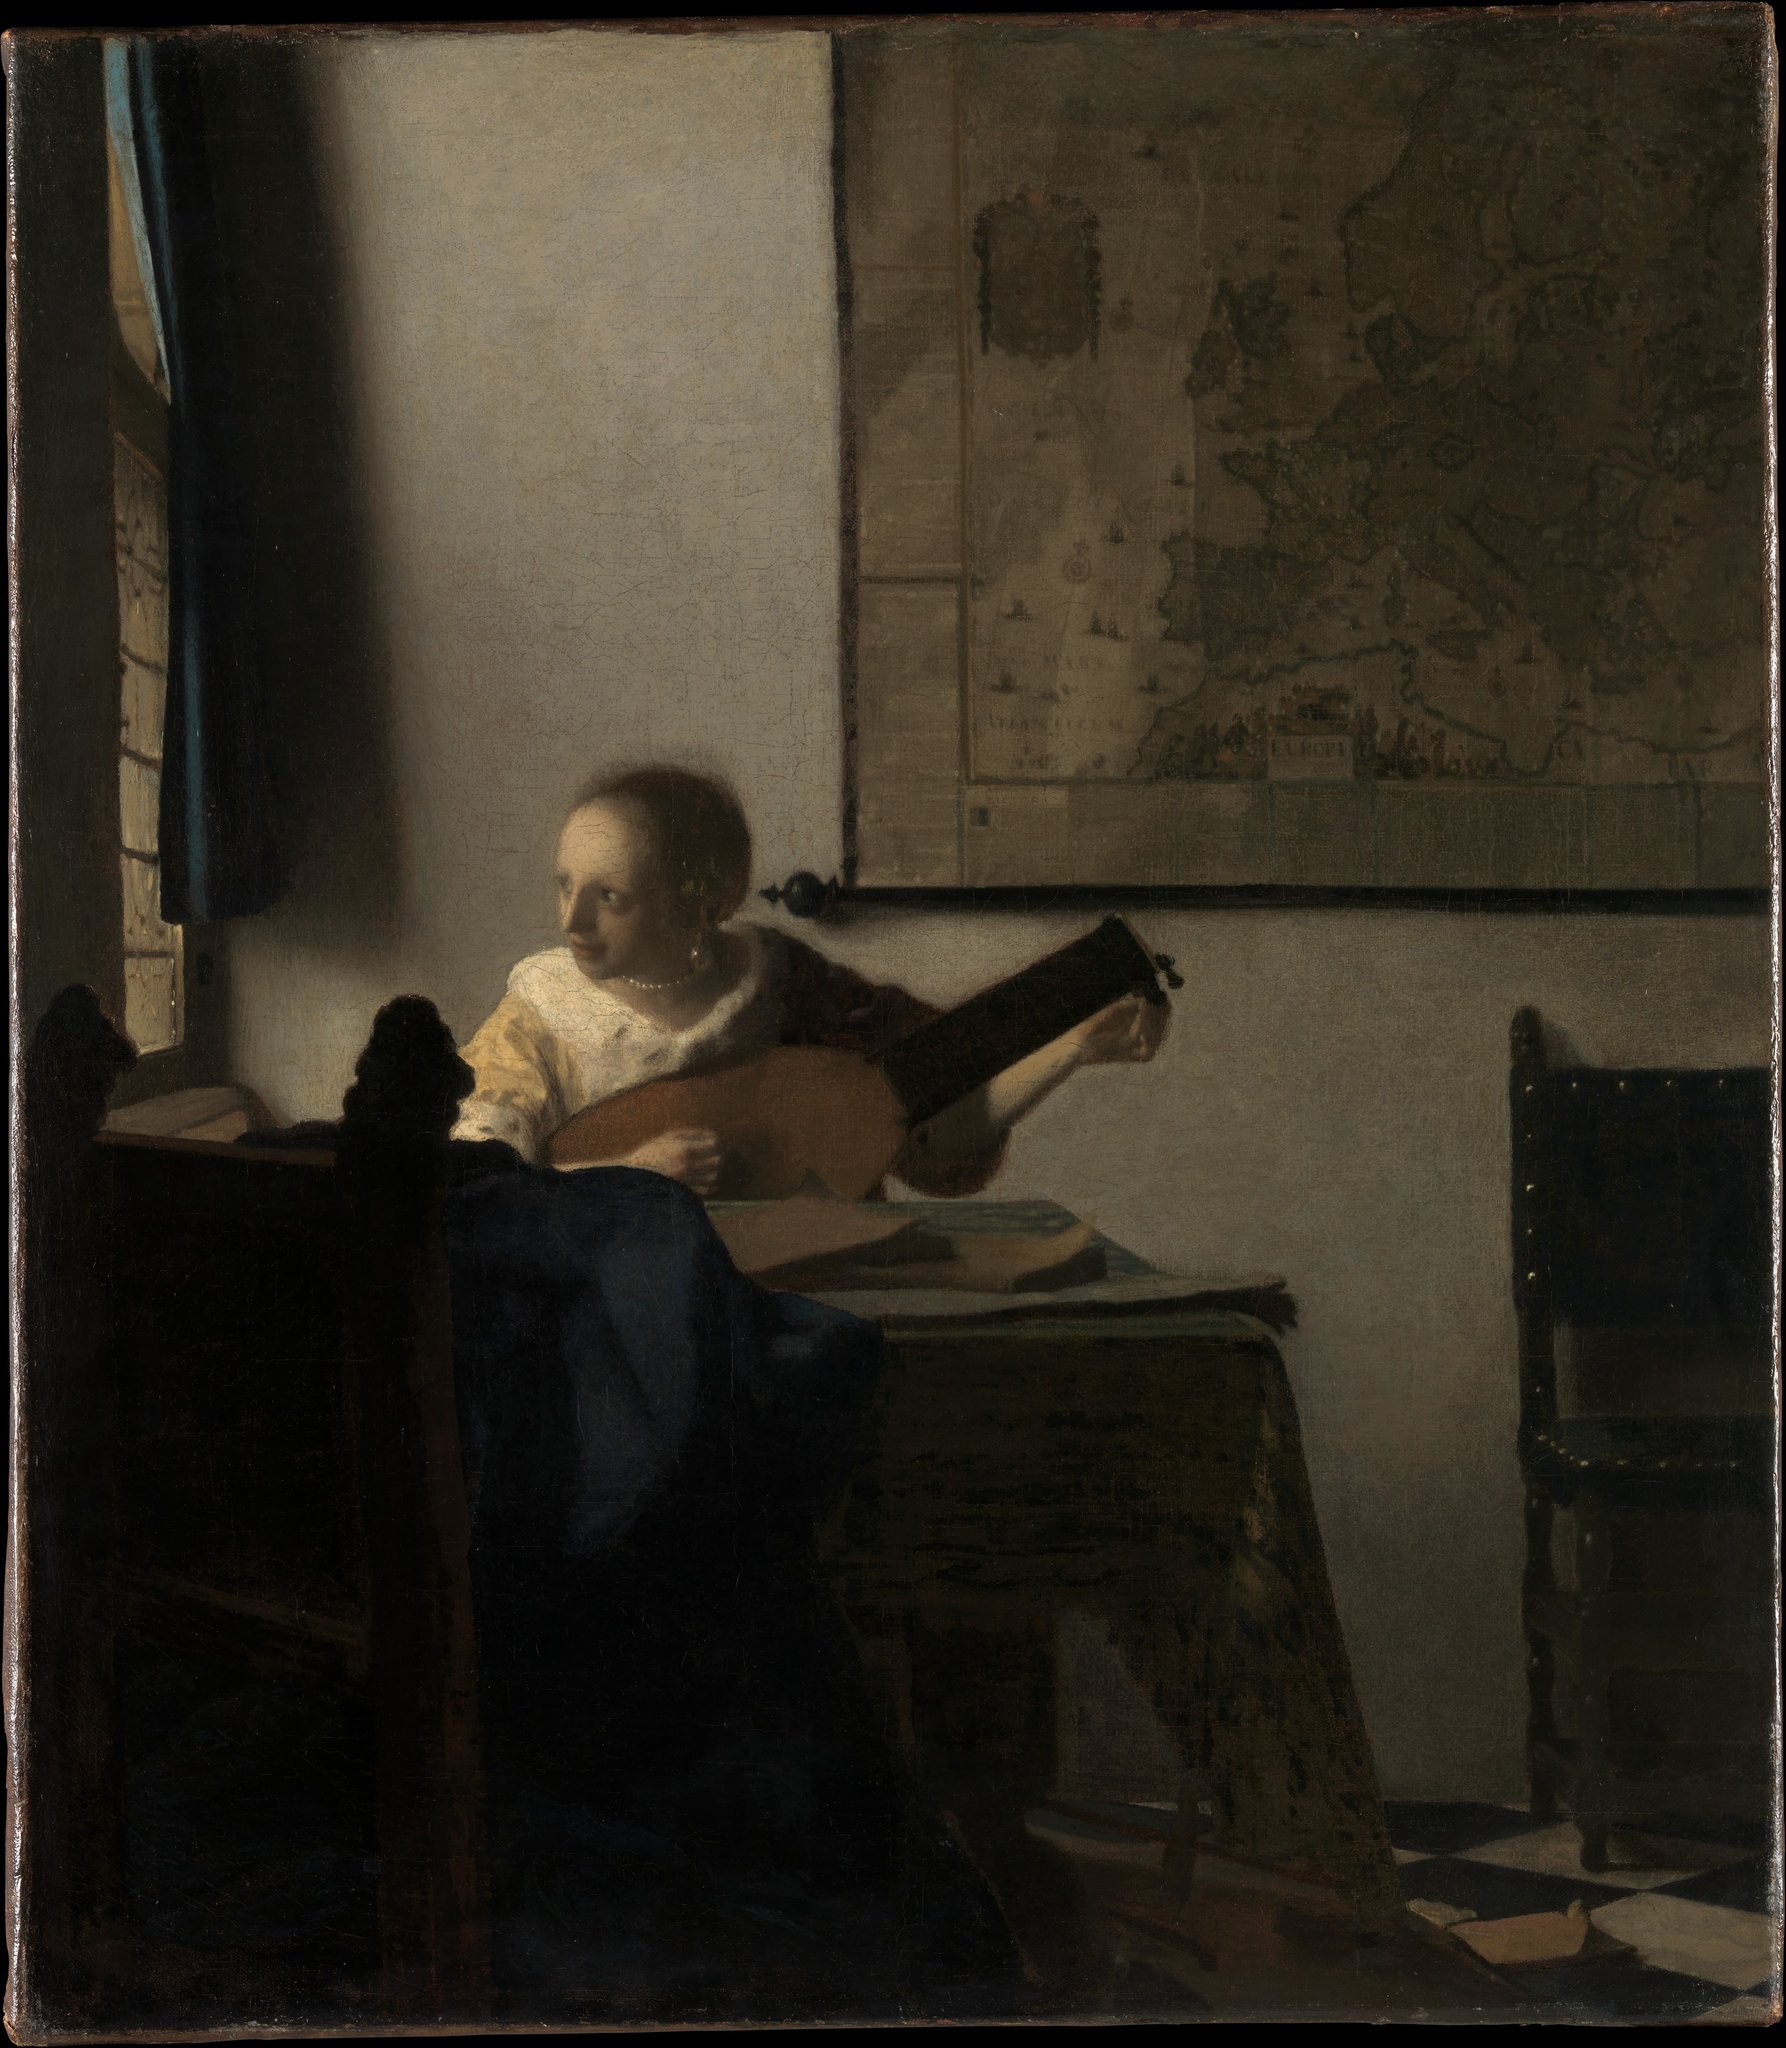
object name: painting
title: Young Woman with a Lute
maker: johannes vermeer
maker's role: artist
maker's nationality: dutch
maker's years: 1632-1675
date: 1662-1663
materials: canvas, oil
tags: interiors,women,music,lutes,maps